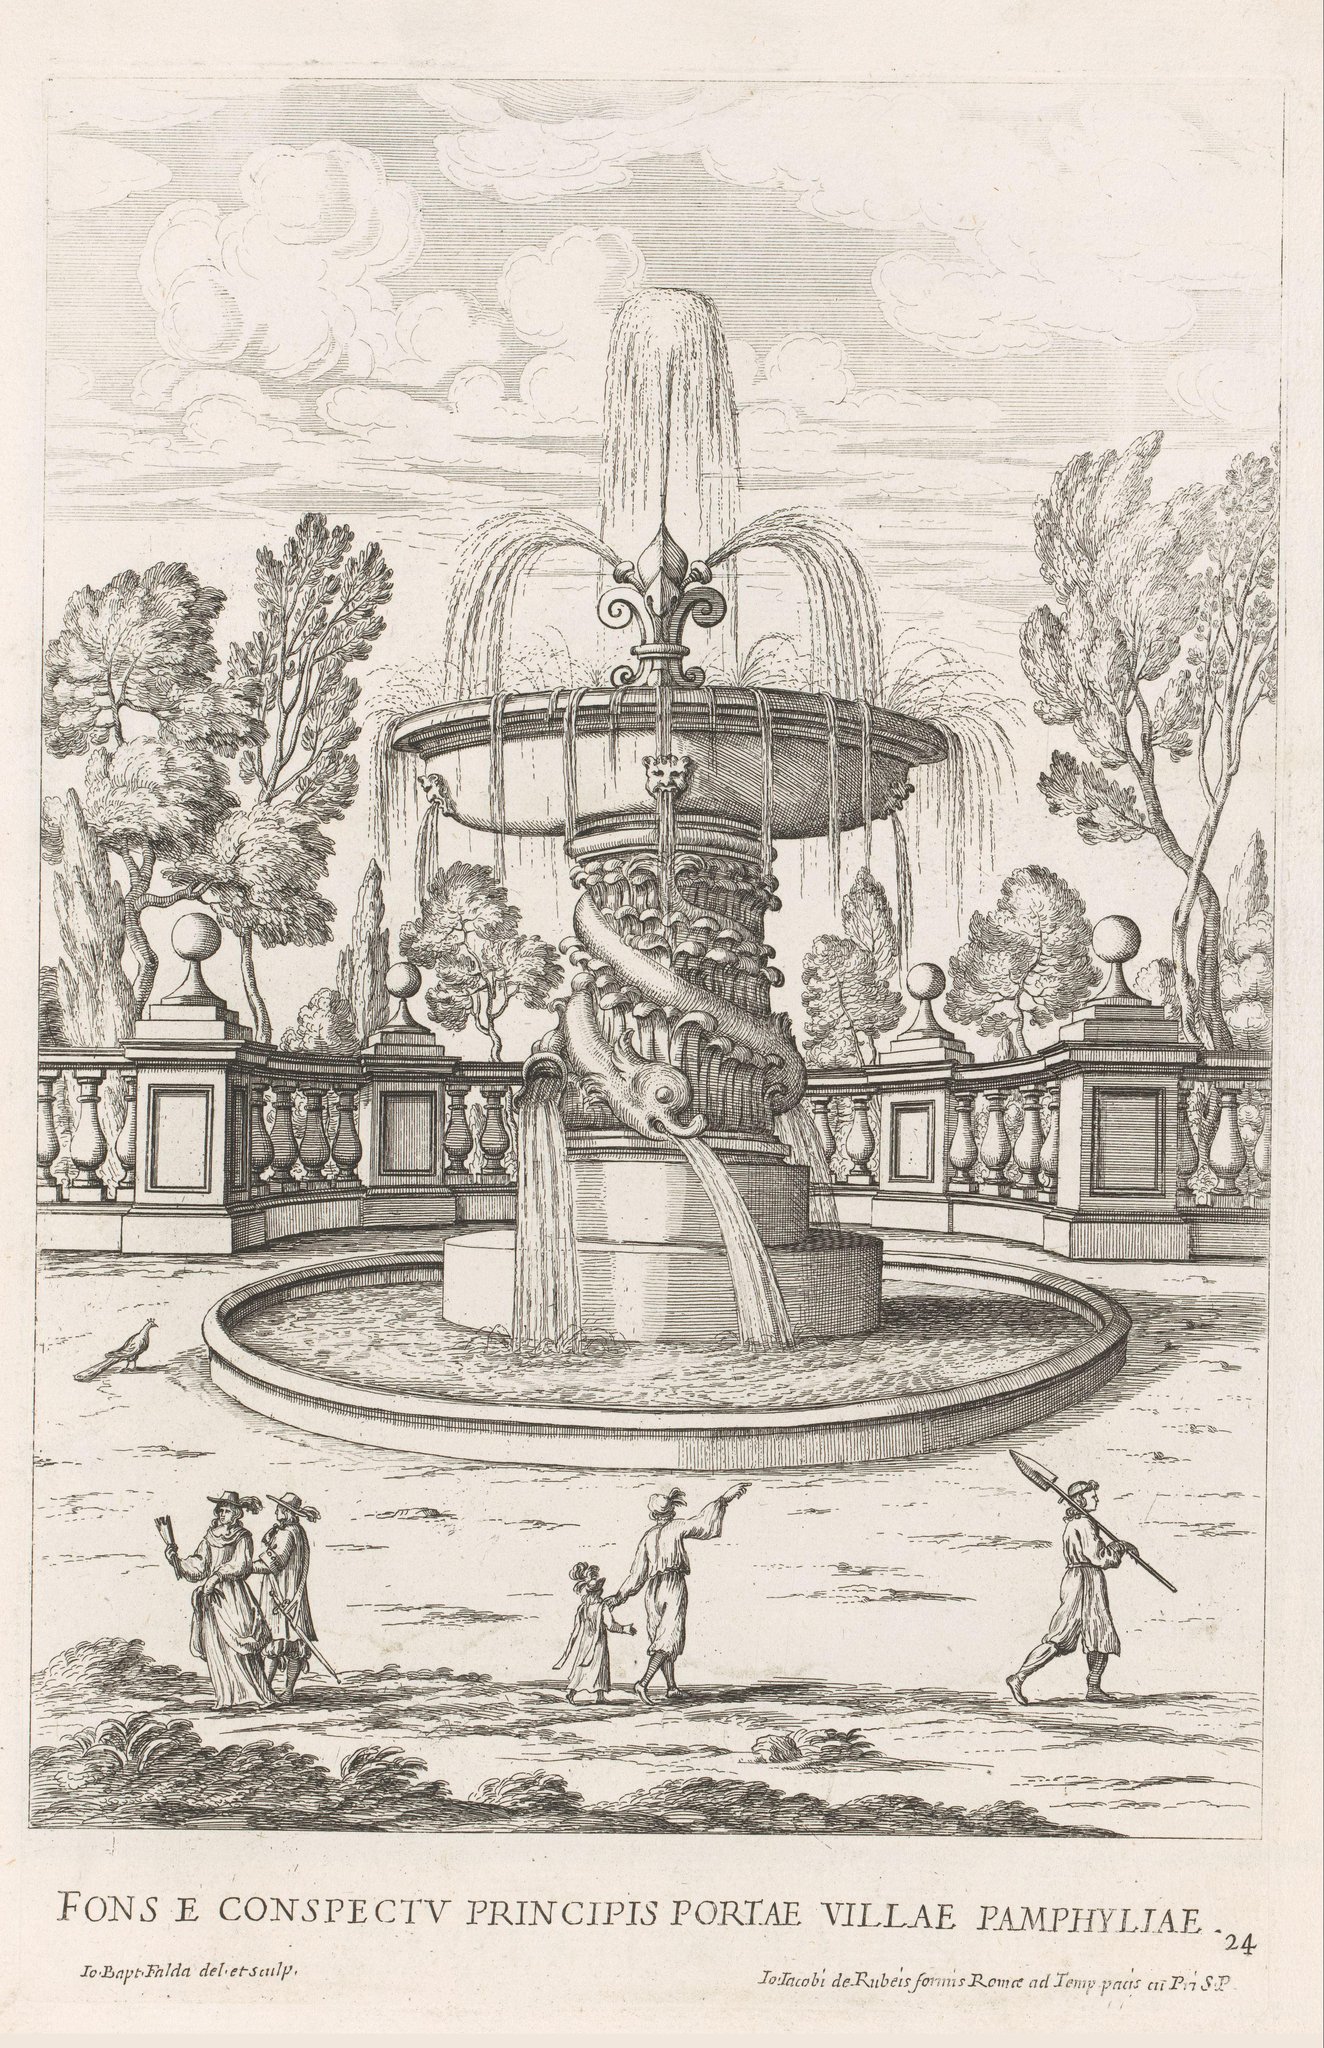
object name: print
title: Fontein met dolfijnen in de tuinen van Villa Doria Pamphilj te Rome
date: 1653-1691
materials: paper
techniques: etching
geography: rome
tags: swimming mammals: dolphin, ornamental fountain, rome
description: Genummerd rechtsonder: 24. De prent maakt deel uit van een album.